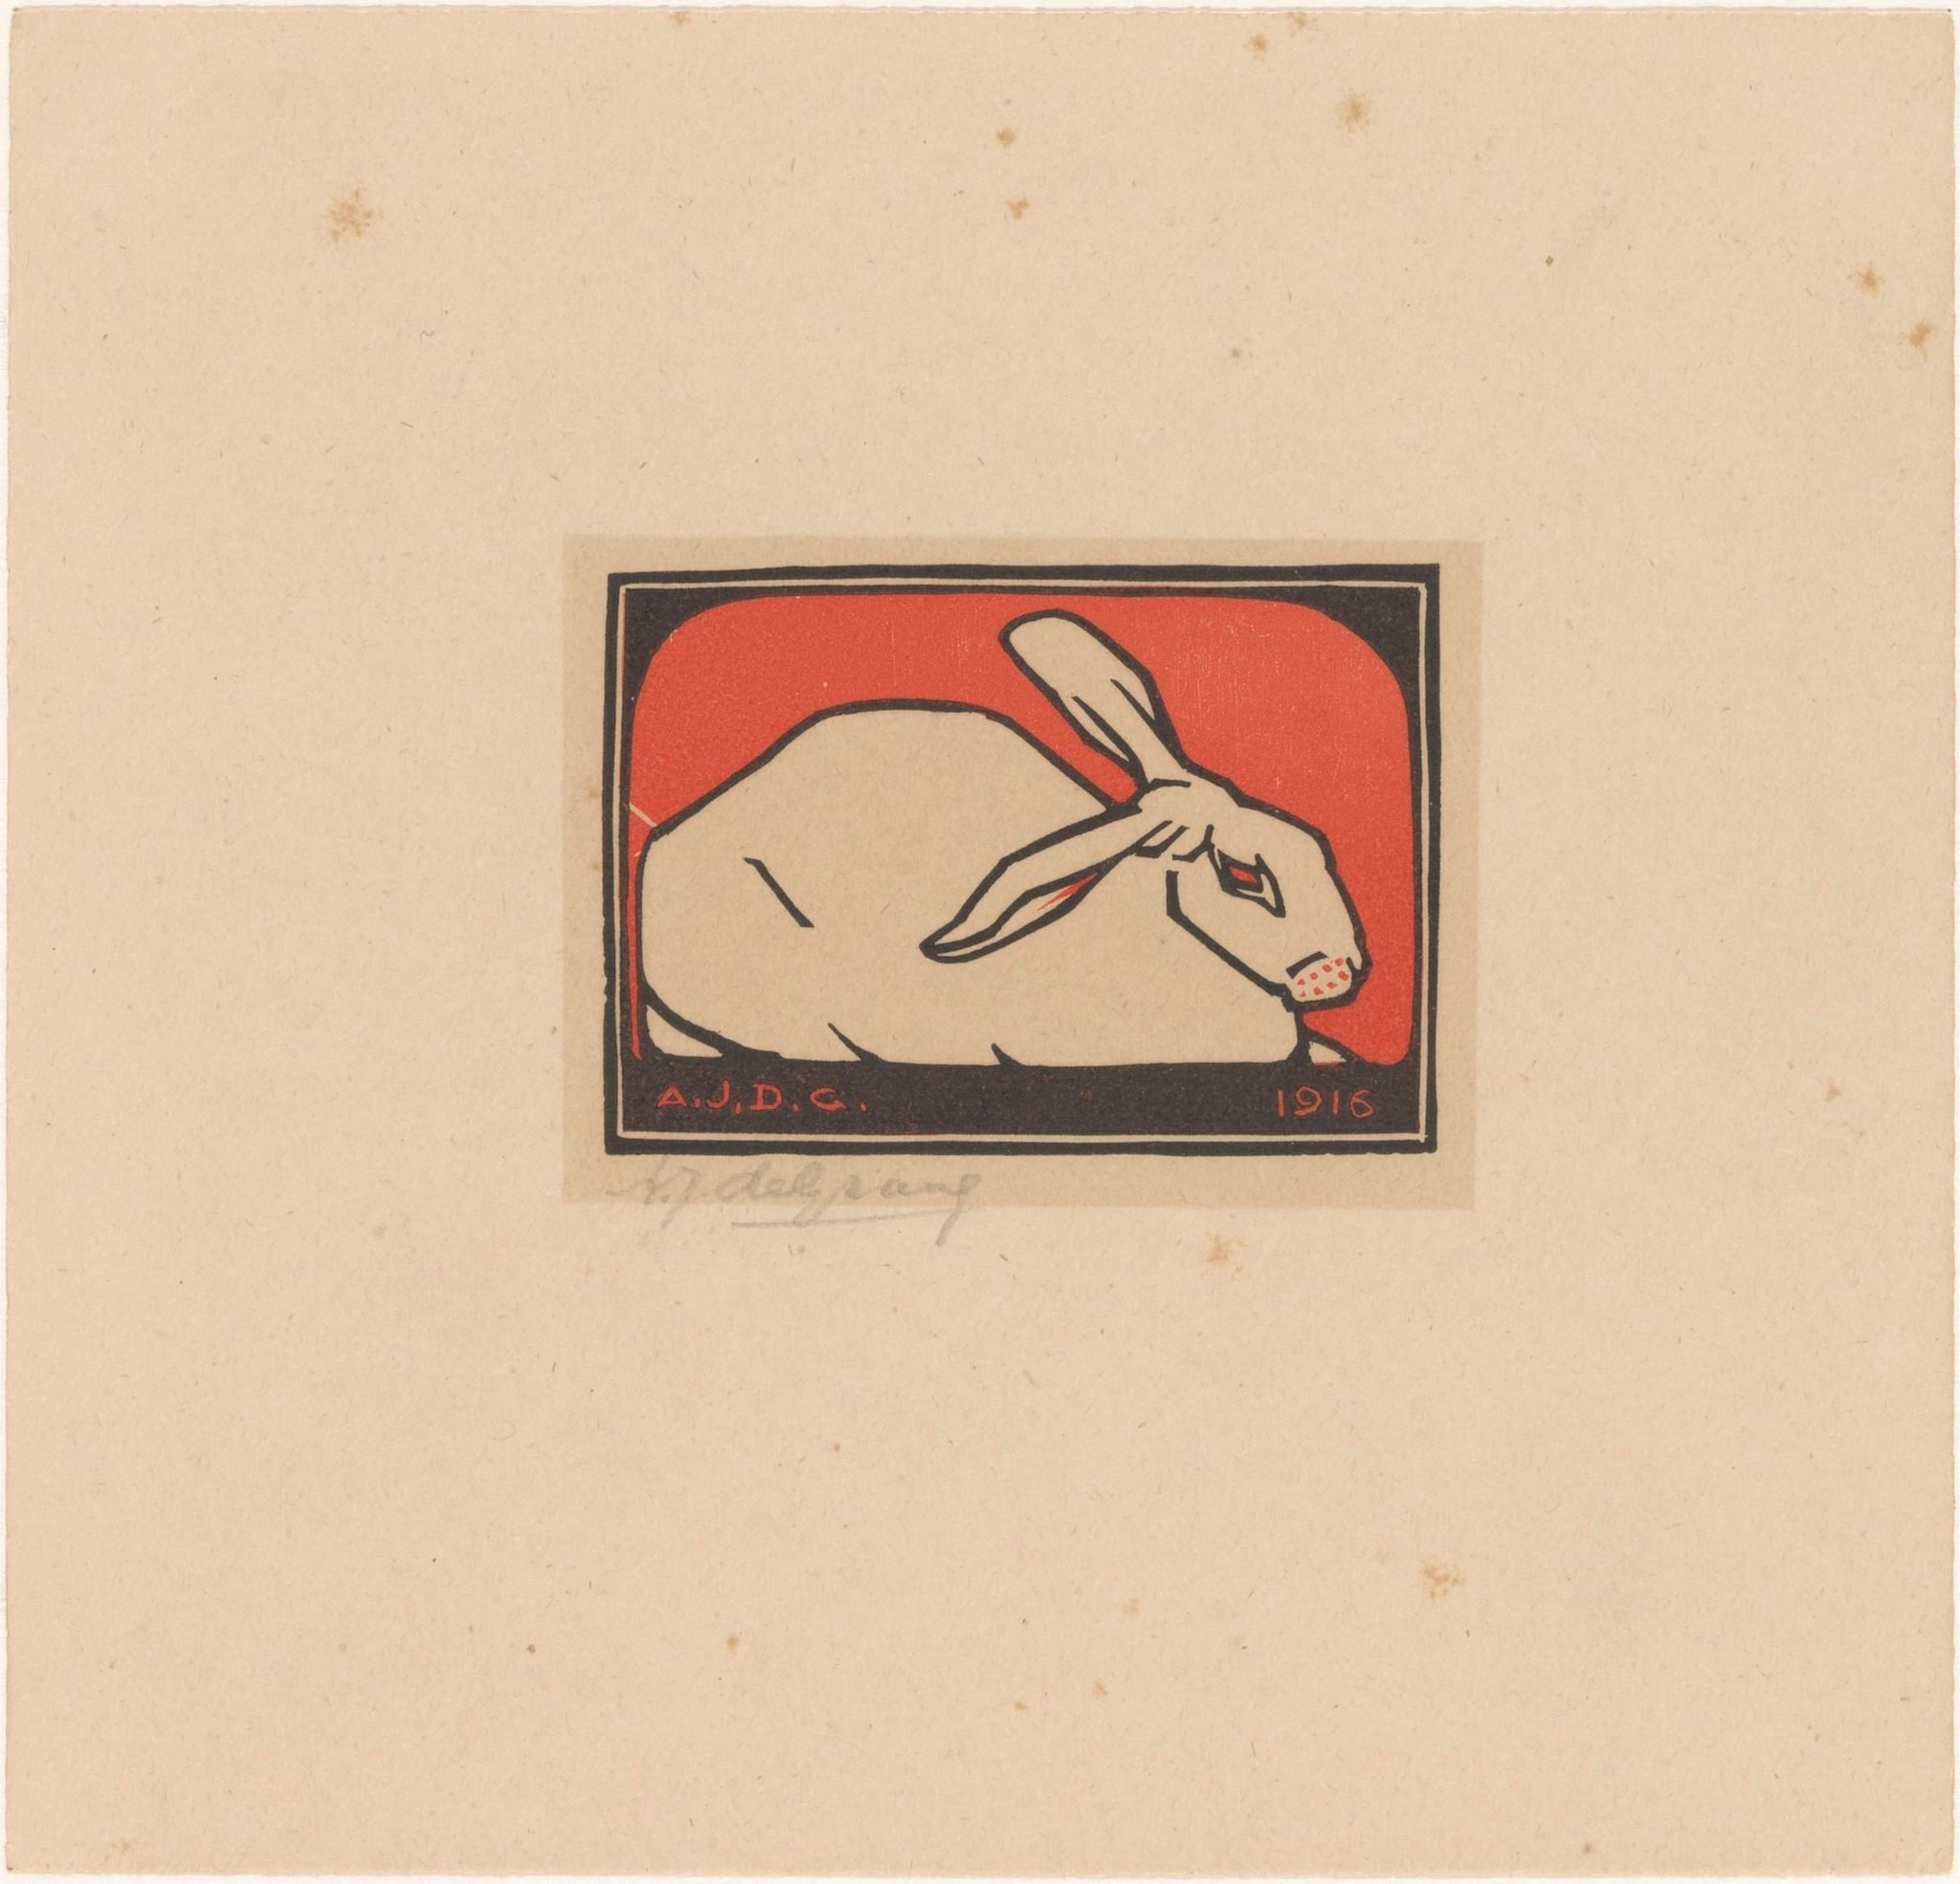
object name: print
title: Liggend konijn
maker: julie de graag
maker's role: draughtsman, print maker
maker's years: 1877-1924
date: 1916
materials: paper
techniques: woodcut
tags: rodents: rabbit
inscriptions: collector's mark: Lugt 2228